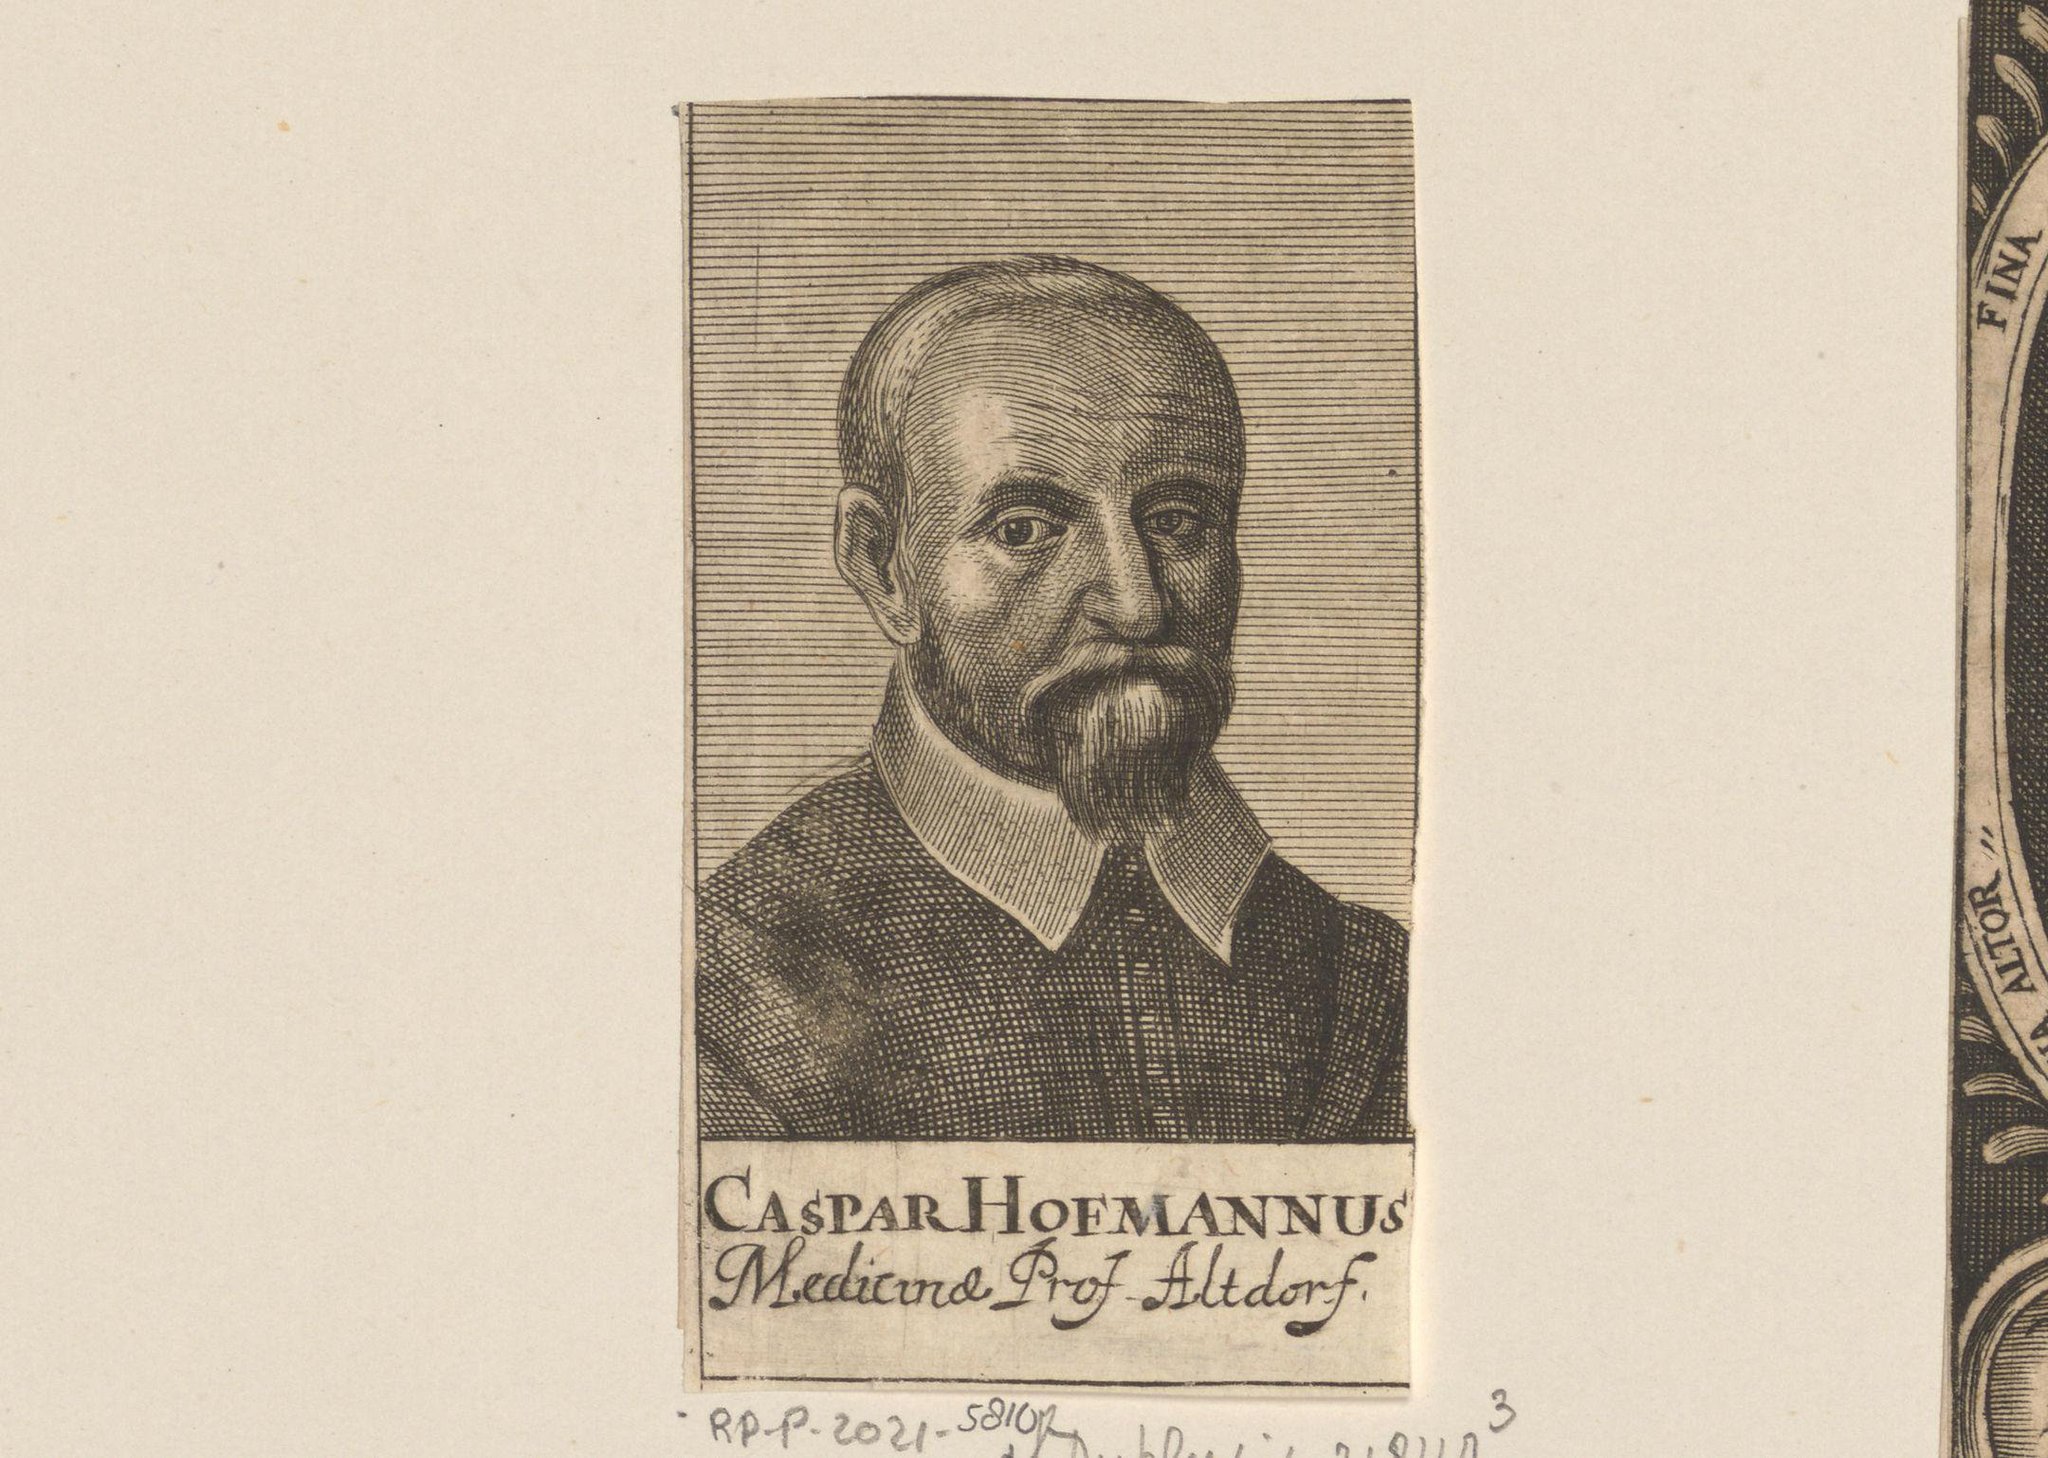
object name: print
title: Portret van Caspar Hoffmann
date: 1688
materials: paper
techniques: engraving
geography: nuremberg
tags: historical persons, physician, doctor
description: Prent uit: Freher, Paul. Theatrum virorum eruditione clarorum. Neurenberg: Johann Hoffmann, 1688.